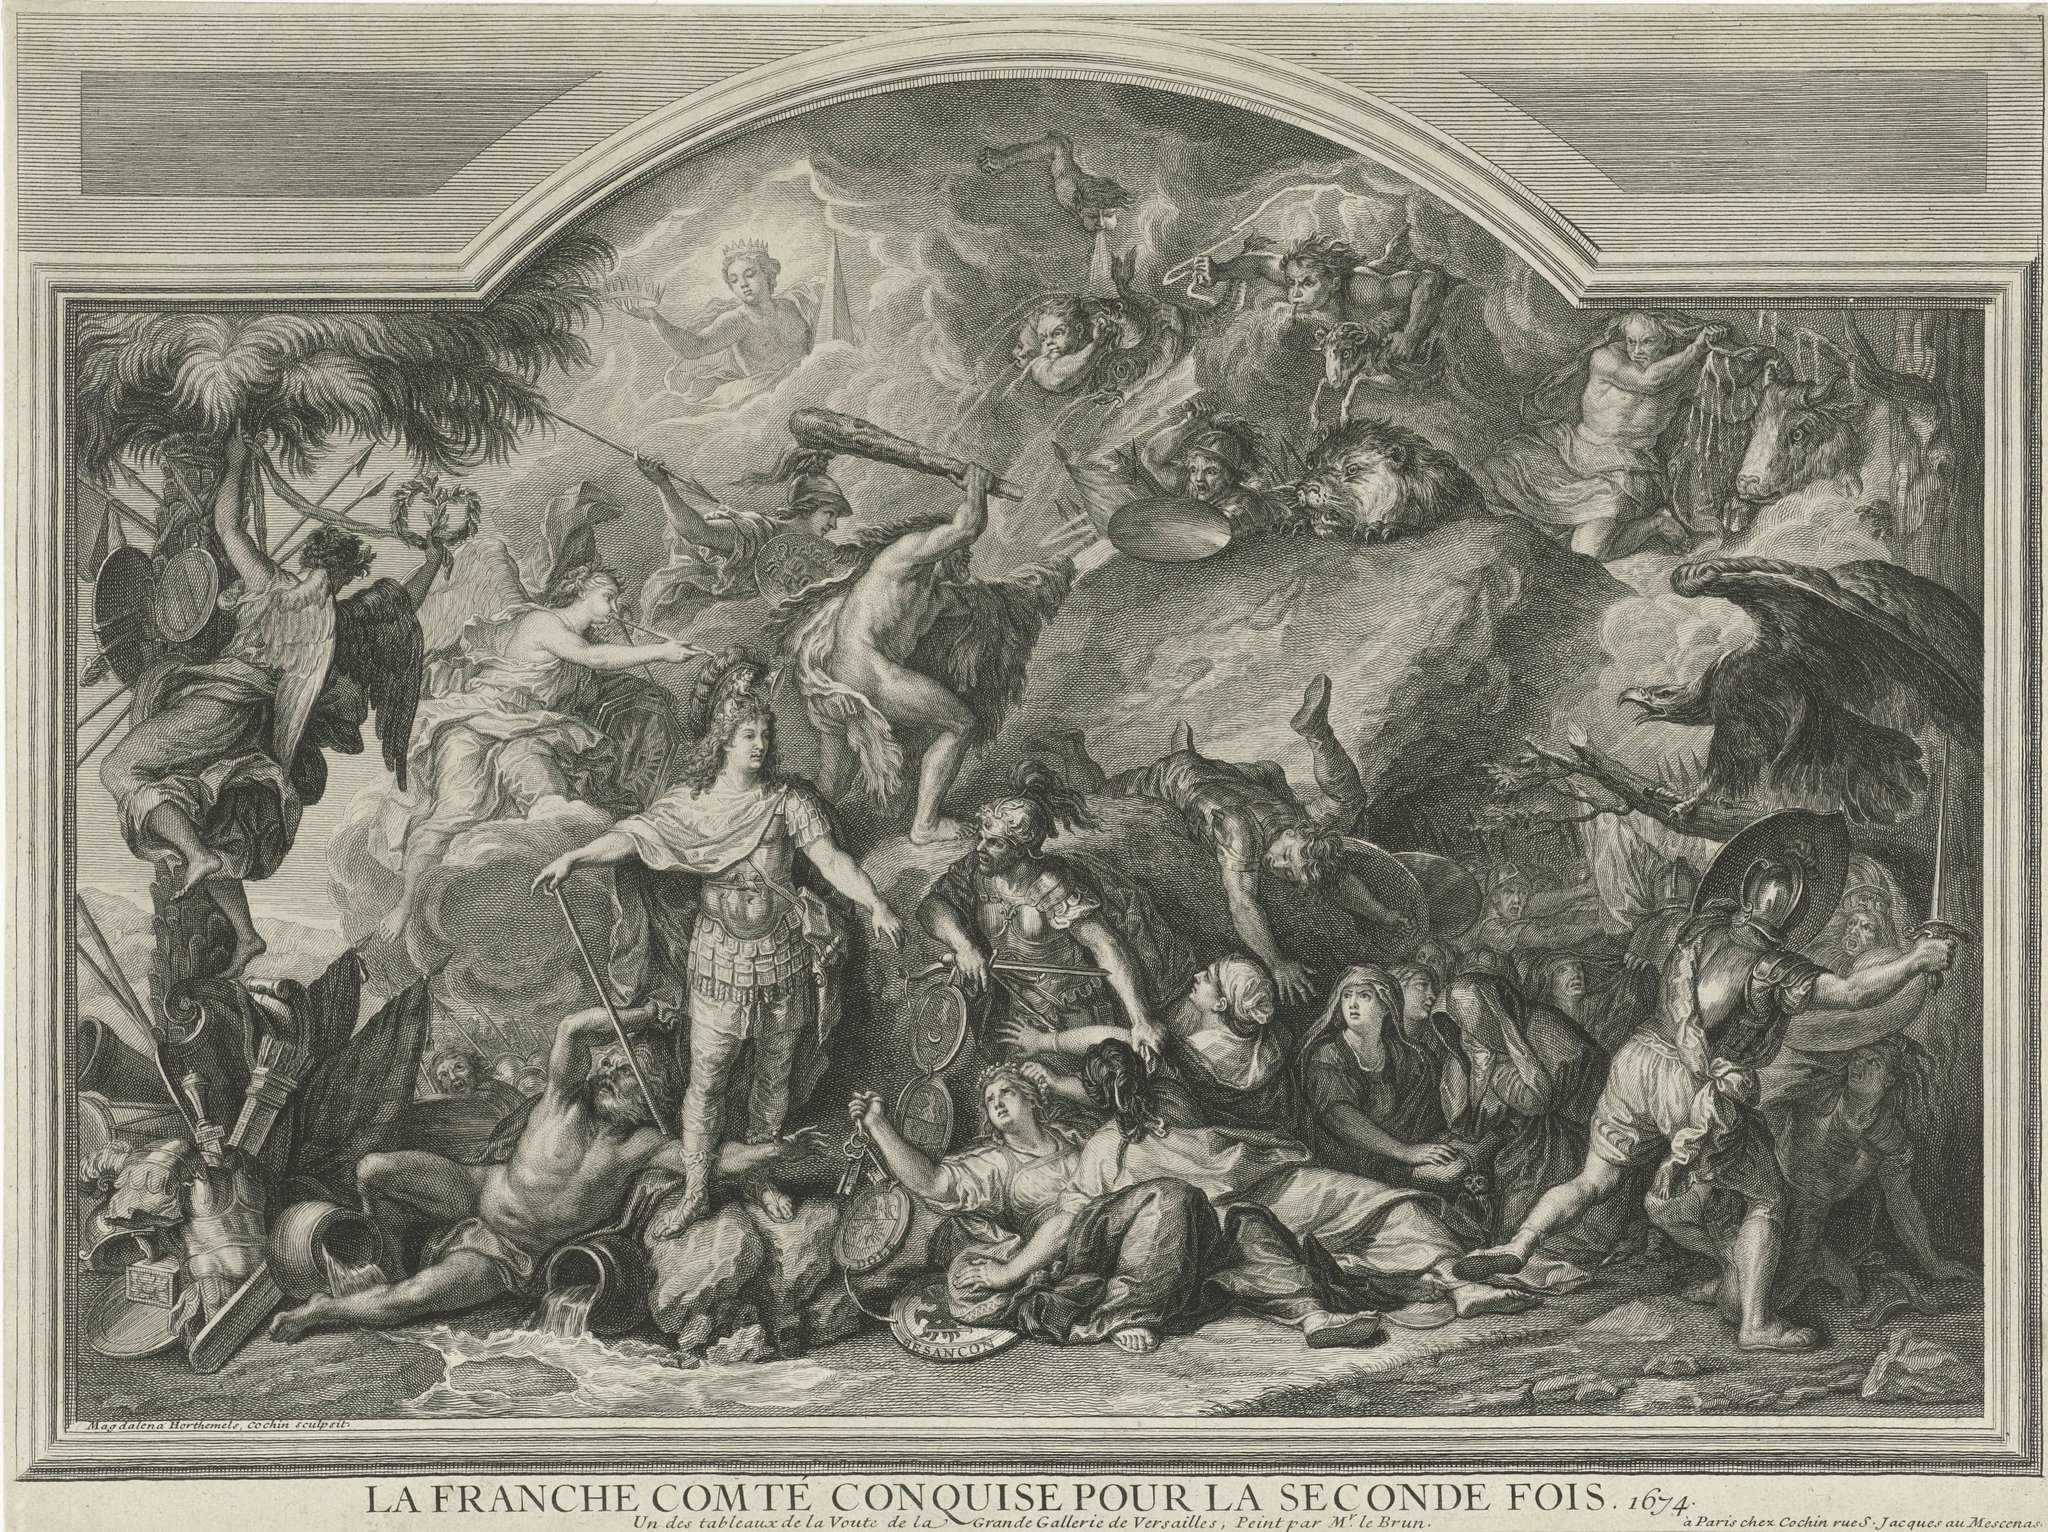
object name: print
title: La Franche comté conquise pour la seconde fois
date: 1696-1767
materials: paper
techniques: engraving, etching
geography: paris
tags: symbols, allegories of war; 'guerra' (ripa)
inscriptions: collector's mark: Lugt 2228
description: Inname van Besancon; Franche-Comté voor de tweede maal door de Fransen heroverd, 1674. In het midden staat de legeraanvoerder Henri de La Tour d’Auvergne (Turenne), die de de stadsleutels aanneemt van de overwonnen stedenmaagd van Besancon, de hoofdstad van de Spaanse regio Franche-Comté, die door de Fransen wordt heroverd in 1674.